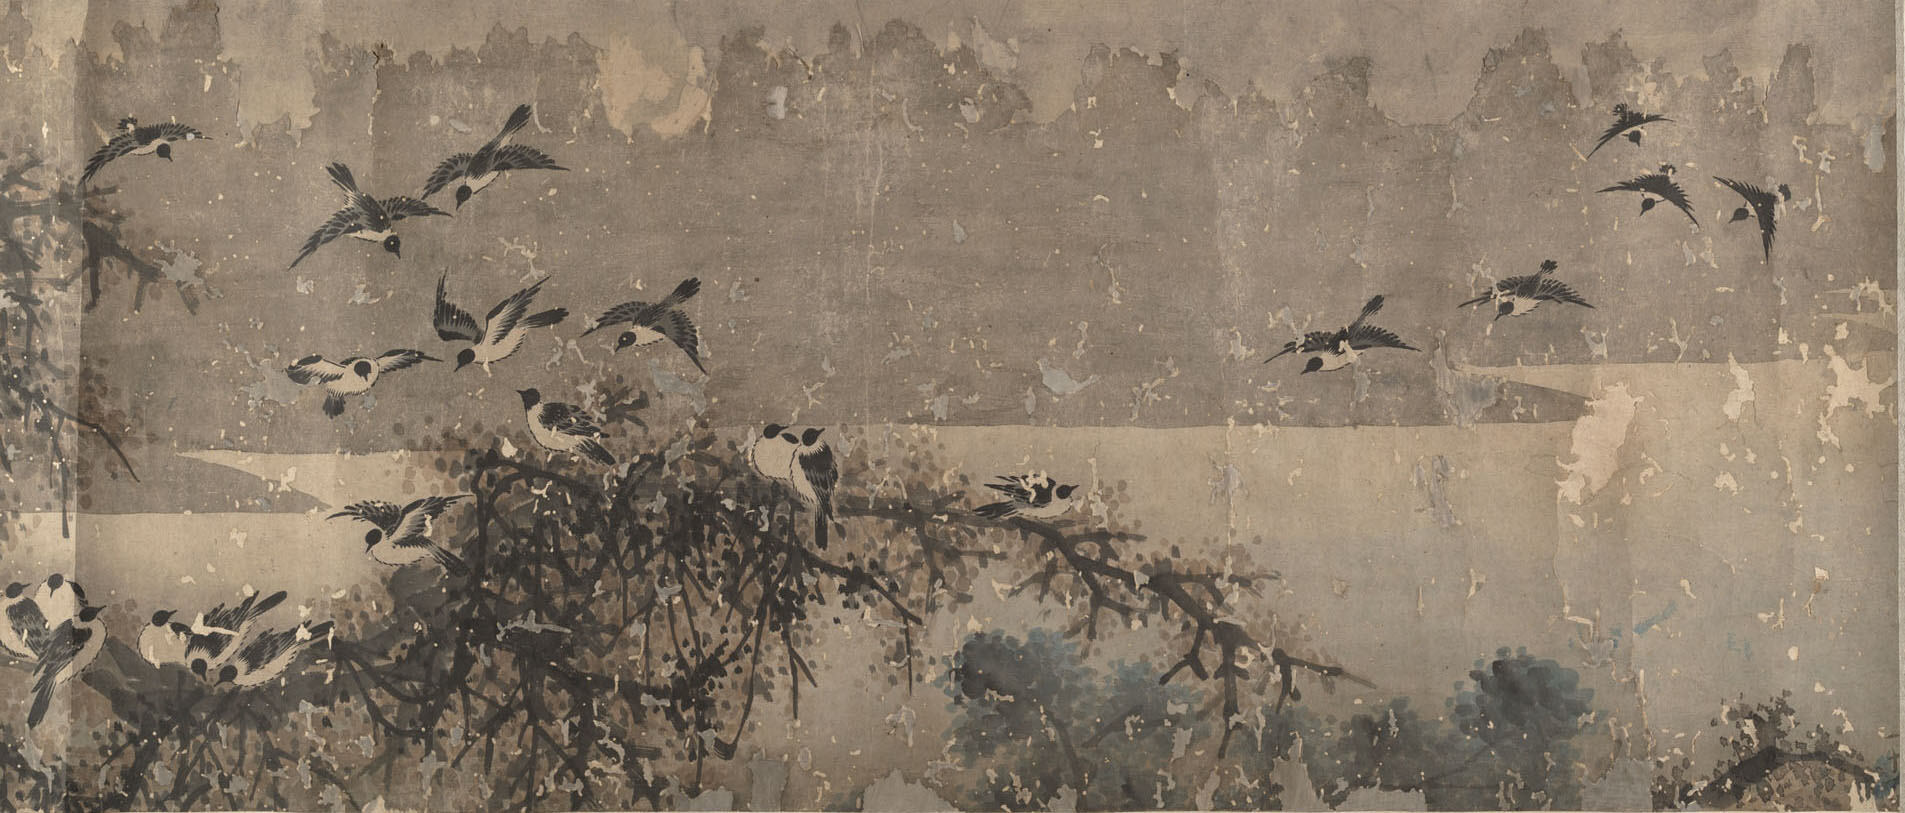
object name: handscroll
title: Landscape with White-Breasted Crows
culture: chinese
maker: zha shibiao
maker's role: artist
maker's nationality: chinese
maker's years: 1615-1698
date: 1615-1698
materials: ink, paper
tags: birds,landscapes